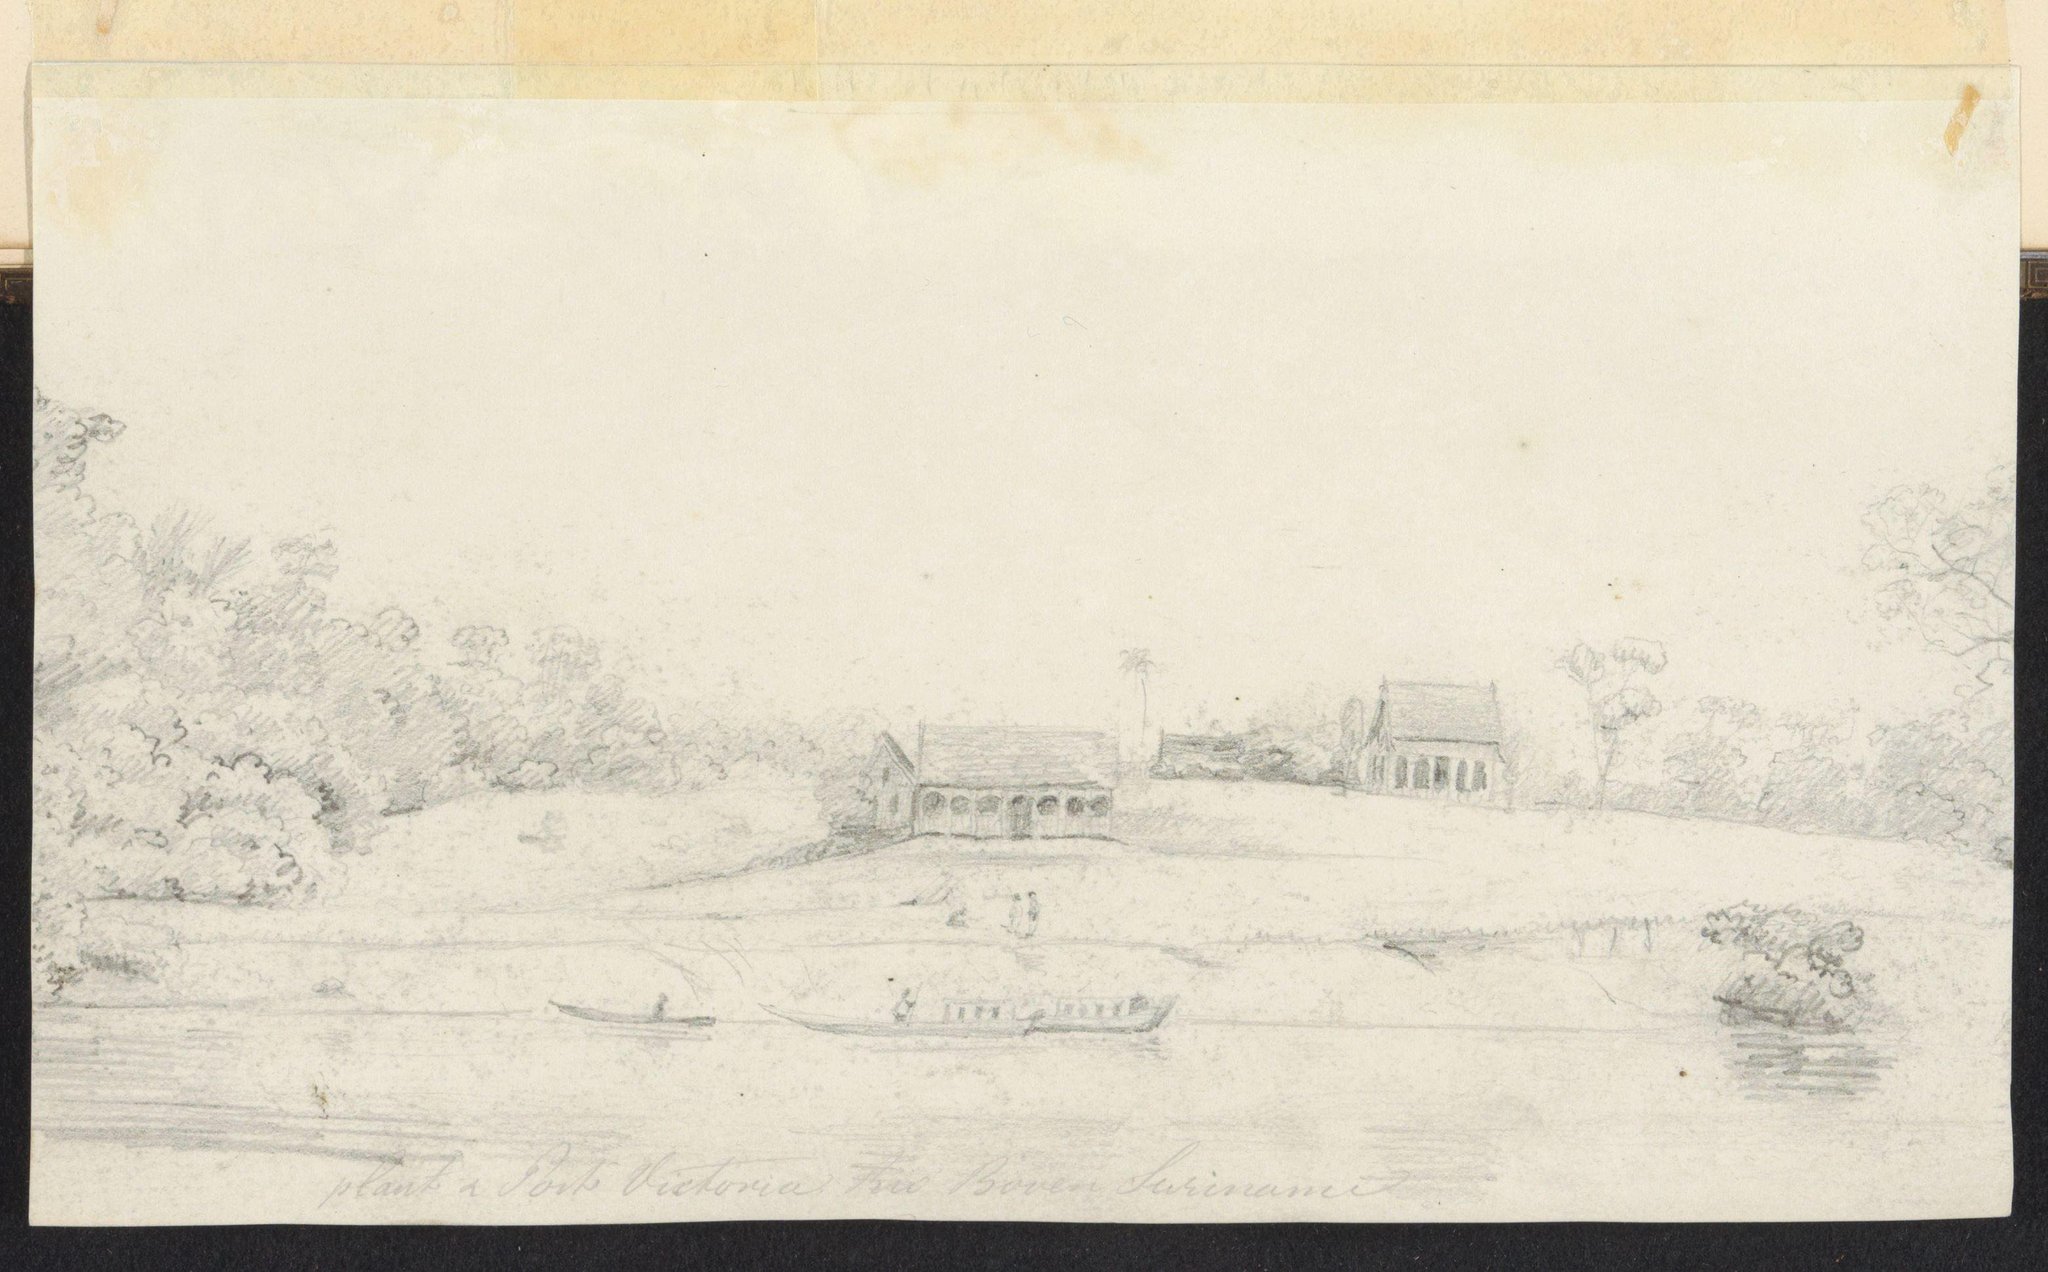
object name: album leaf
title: Post Victoria gezien vanaf de Suriname rivier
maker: jacob marius adriaan martini van geffen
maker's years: 1821-1866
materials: paper, pencil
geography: upper suriname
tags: suriname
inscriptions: inscription: ‘.’